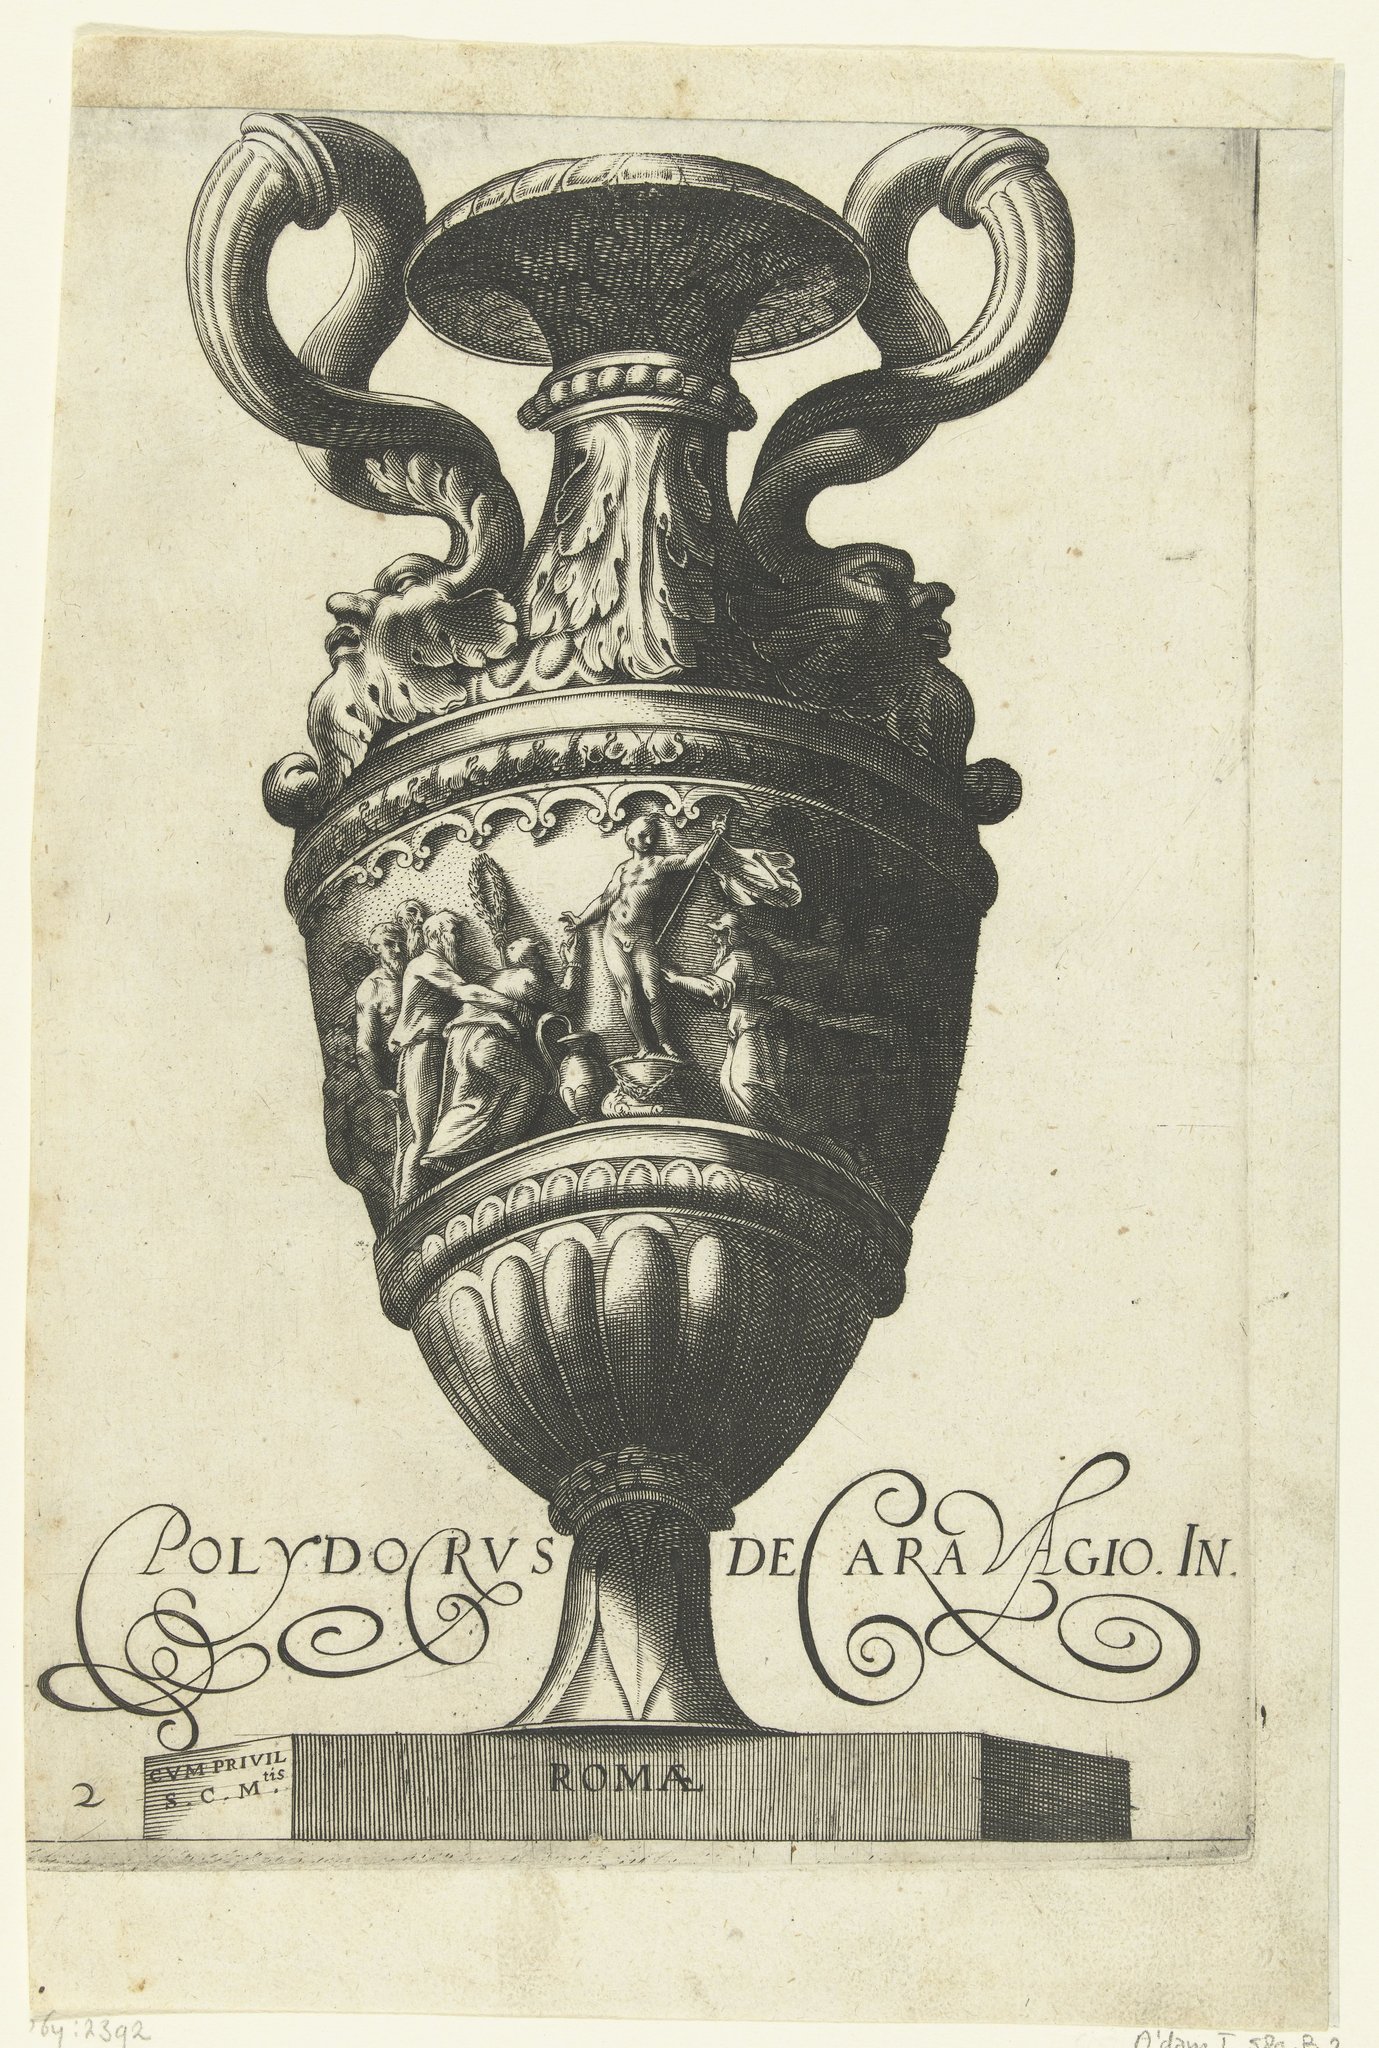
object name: print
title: Vaas met twee gedraaide oren, beginnend en eindigend in eenzelfde mascaron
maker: aegidius sadeler (ii)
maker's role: draughtsman, print maker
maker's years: 1568-1629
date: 1580-1605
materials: paper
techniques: engraving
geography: prague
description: De buik is gedecoreerd met een fries waarop twee groepen mensen een in het midden staande godheid aanbidden. Tegenzijdige kopie naar RP-P-1964-2384.